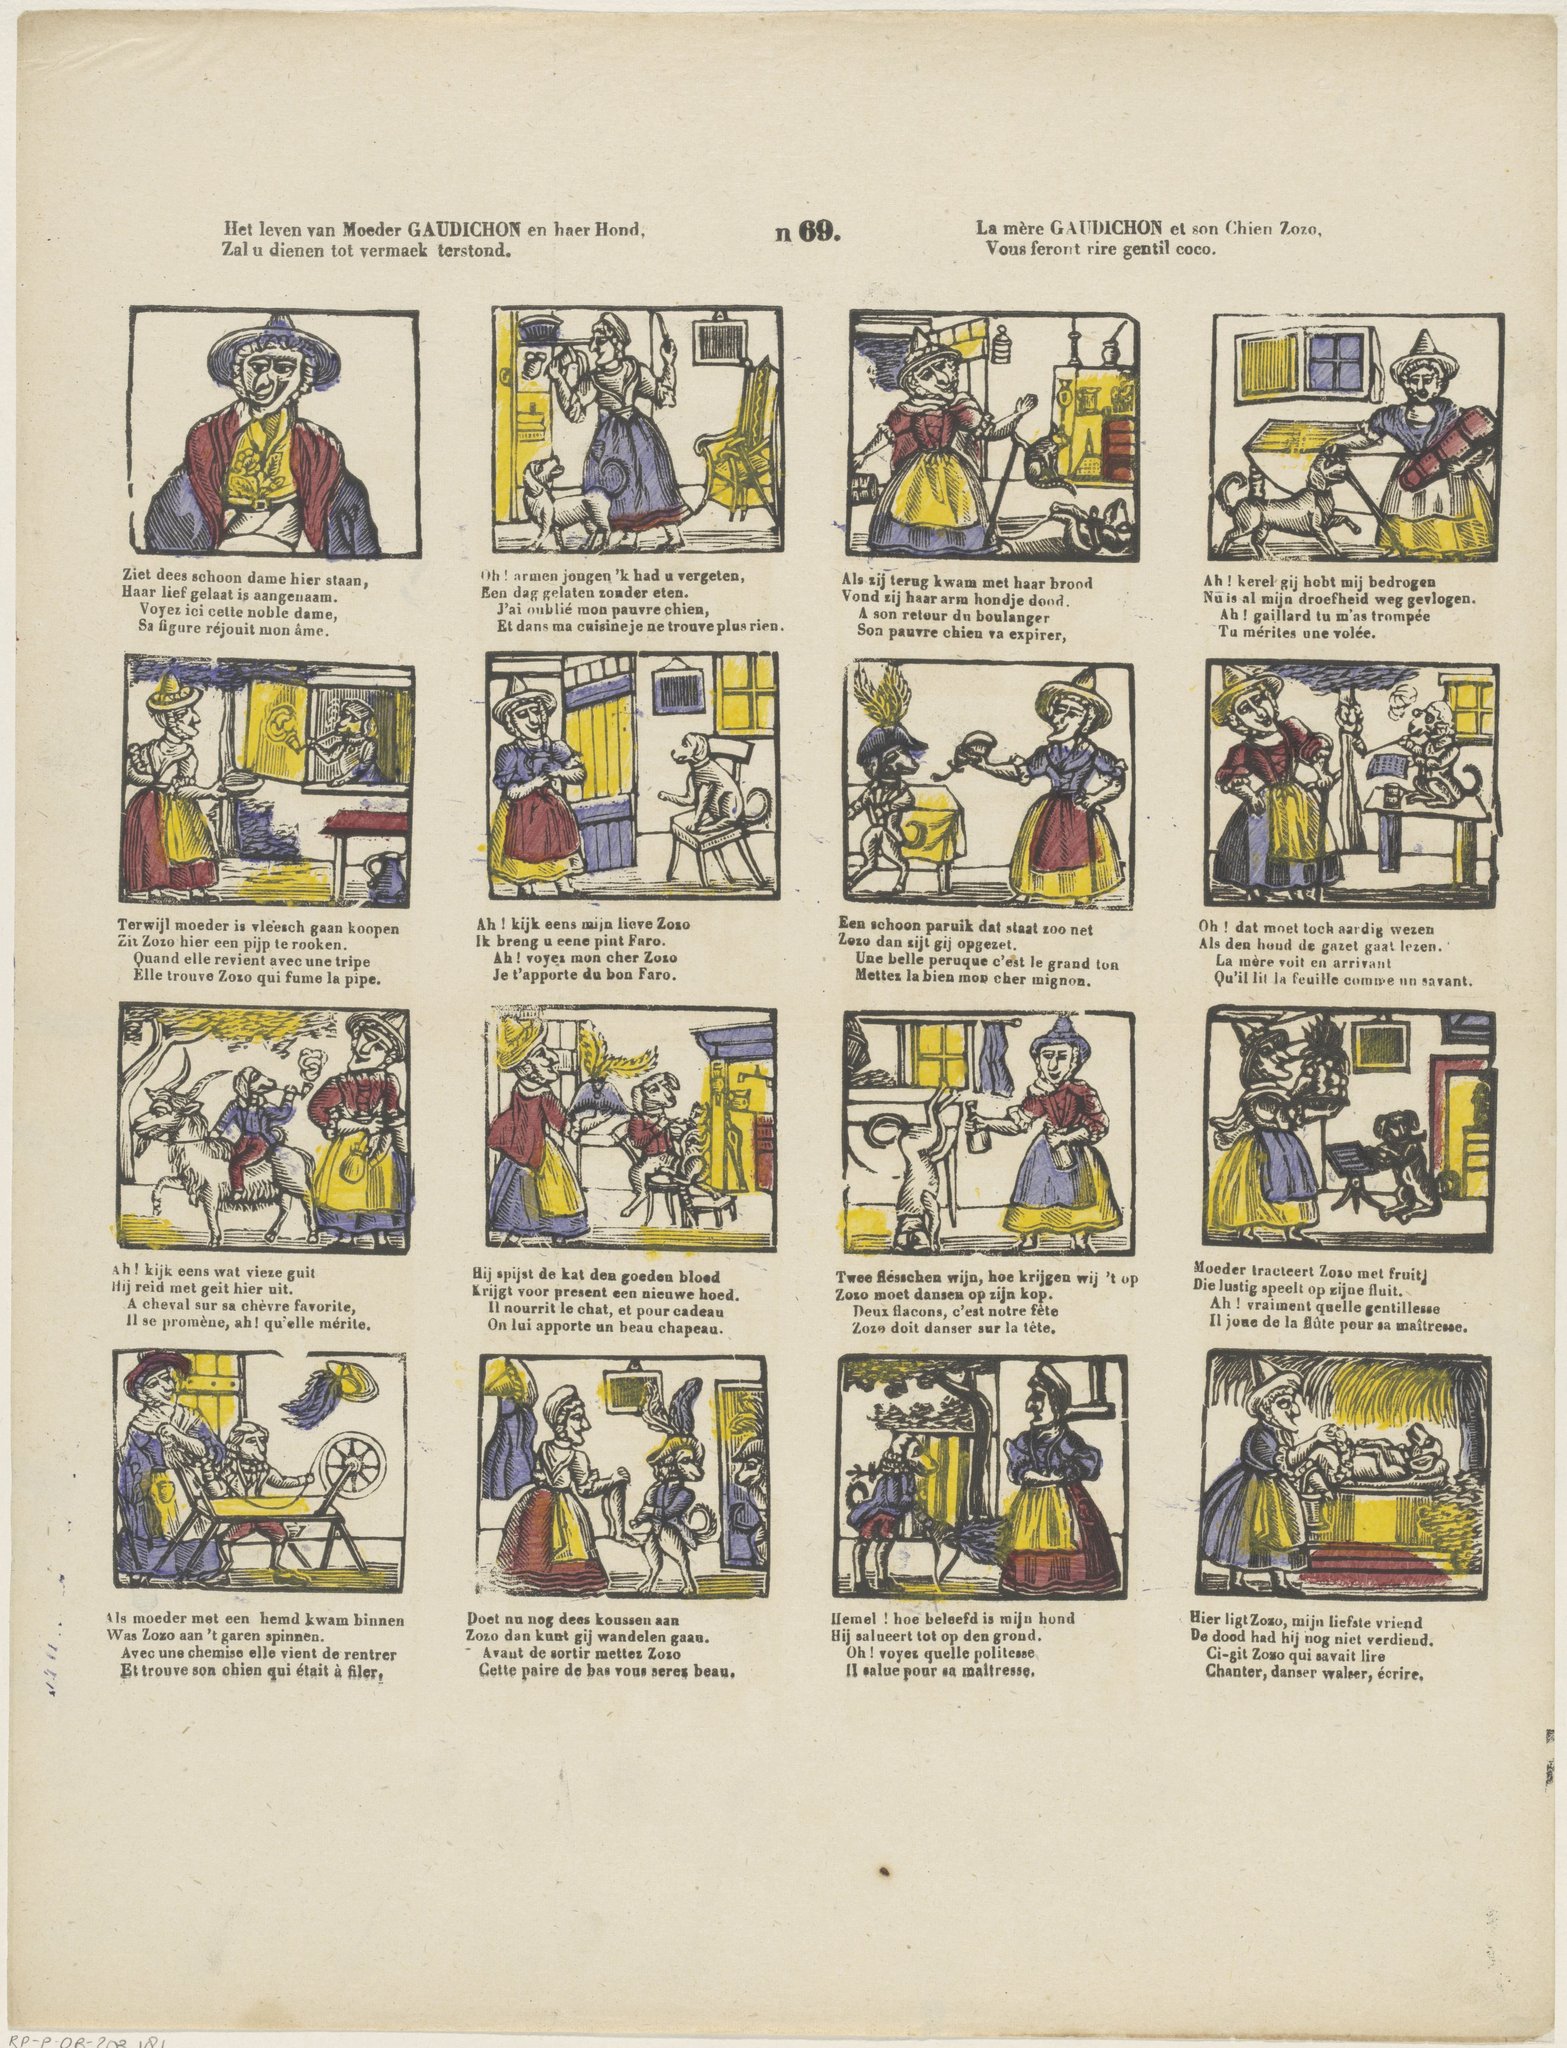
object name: popular print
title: Het leven van moeder Gaudichon en haer hond, / Zal u dienen tot vermaek terstond / La mère Gaudichon et son chien Zozo, / Vous seront rire gentil coco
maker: Anonymous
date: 1856-1900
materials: paper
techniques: colour, letterpress printing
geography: netherlands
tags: 'mundus inversus', the reversed world, the topsy-turvy world, 'le monde bestourné', dog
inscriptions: collector's mark: Lugt 2760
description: Blad met 16 voorstellingen uit het leven van juffrouw Gaudichon en haar hond. De hond kan allerlei kunstjes, waaronder op zijn kop staan, de pijp roken, op de fluit spelen, spinnen, gekleed gaan met schoenen, broek, jas en steek. Onder elke voorstelling een tweeregelig vers in het Nederlands en het Frans. Genummerd midden boven: n 69.